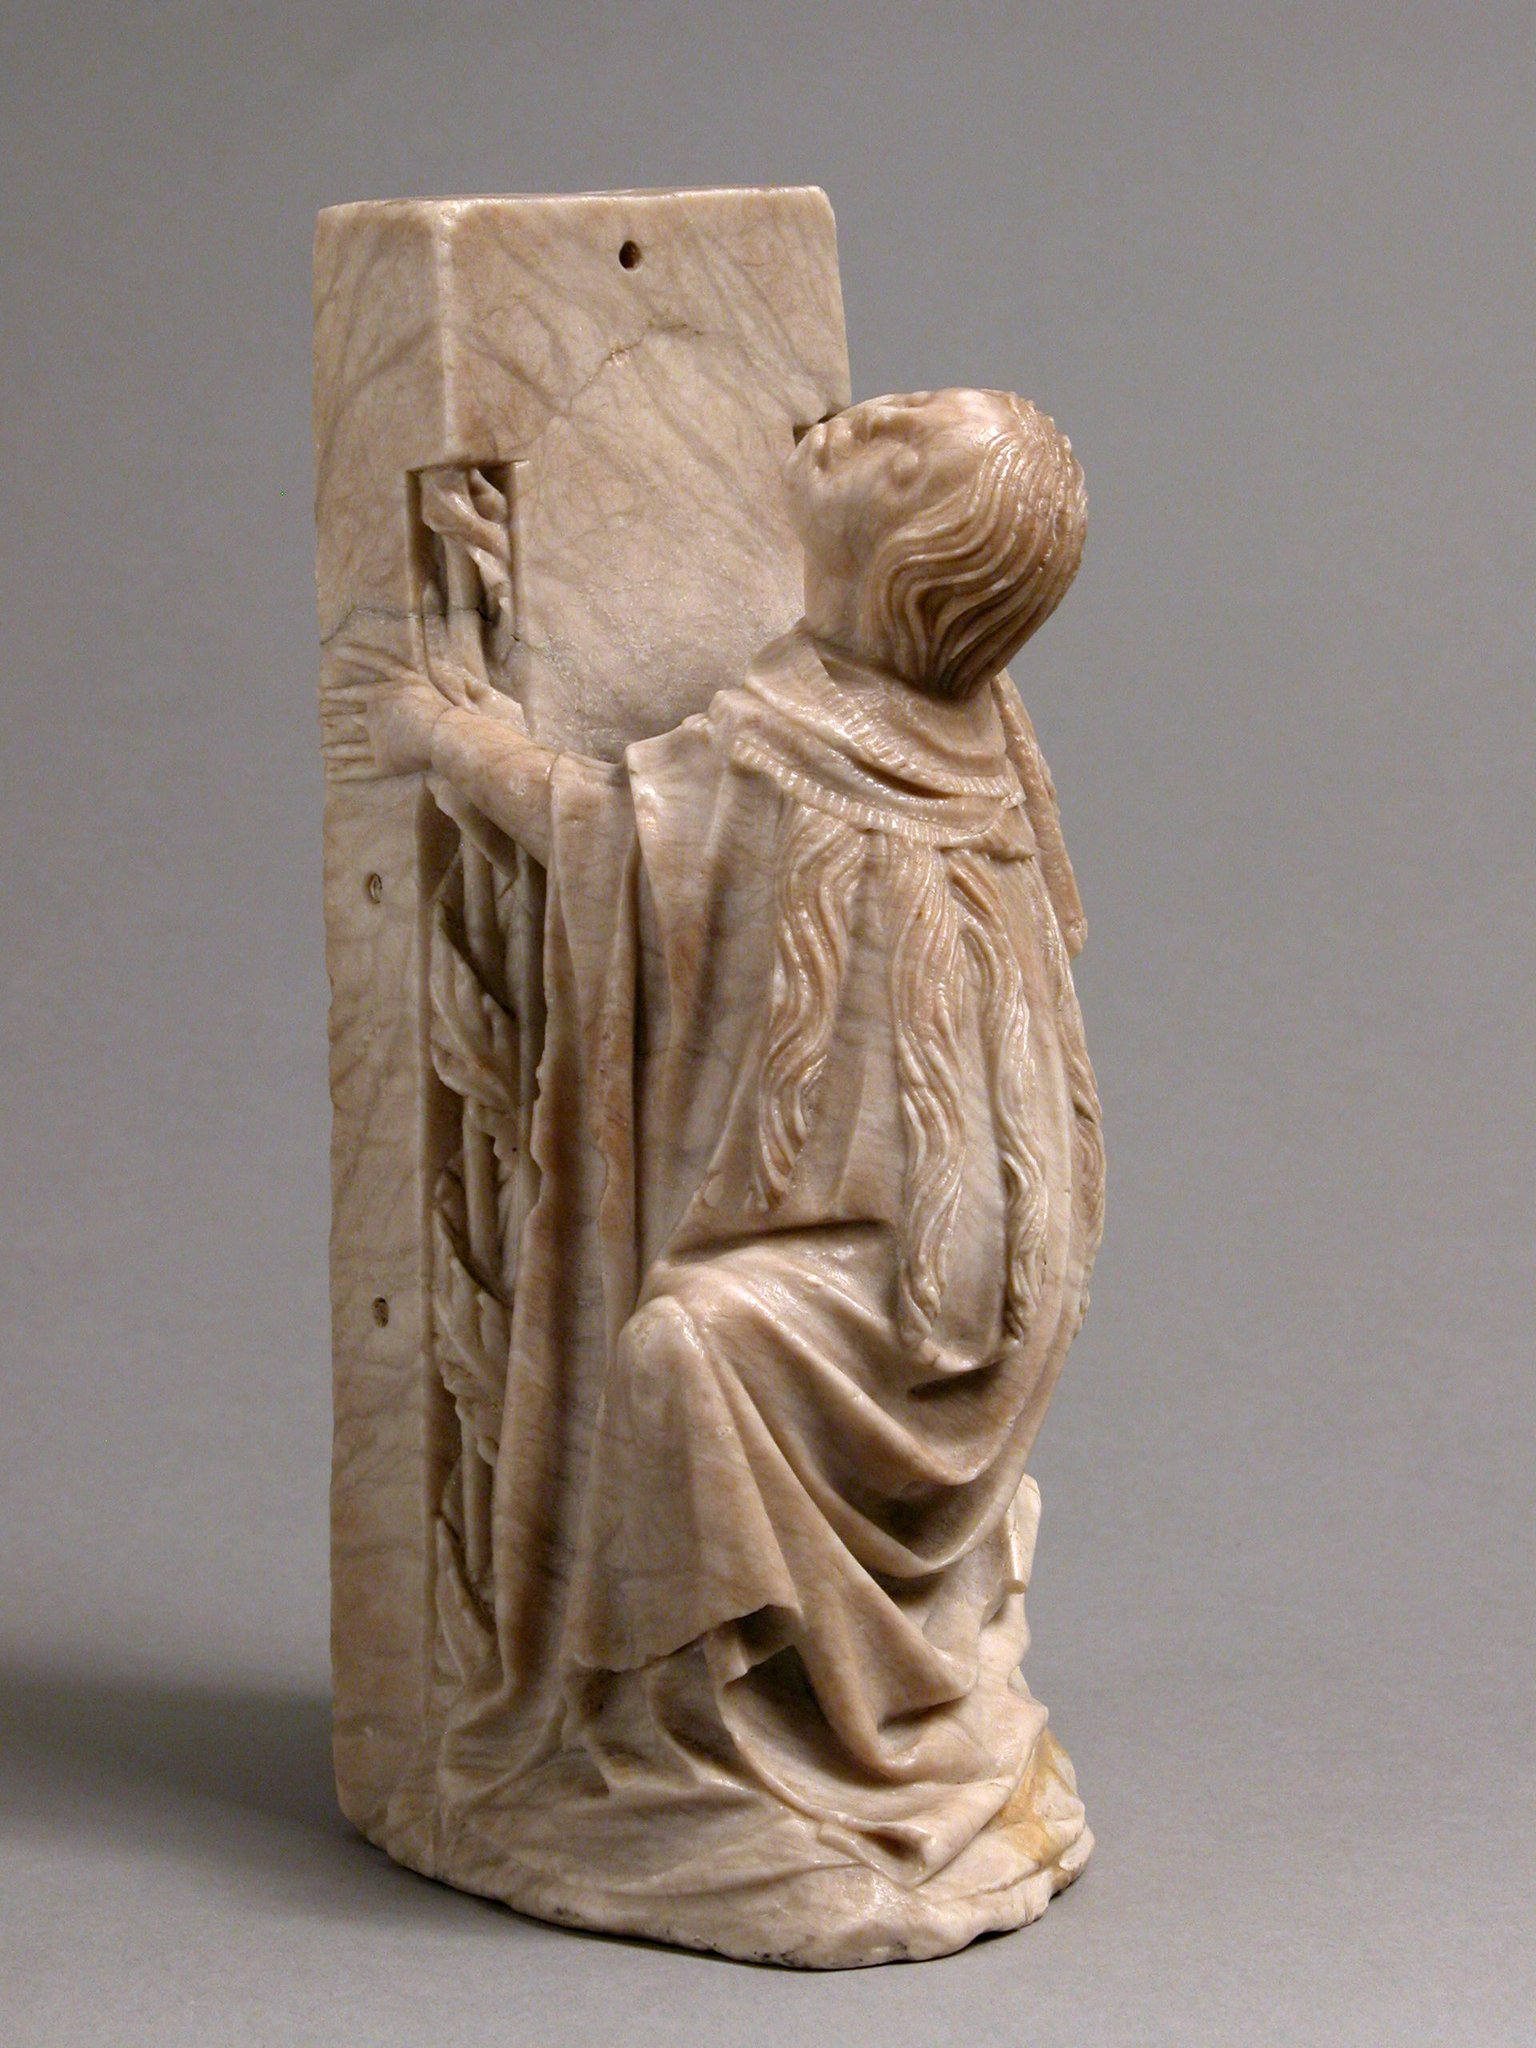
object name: statuette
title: Mary Magdalene at the Foot of the Cross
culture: south netherlandish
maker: master of rimini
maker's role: artist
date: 1420-1430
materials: alabaster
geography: netherlands